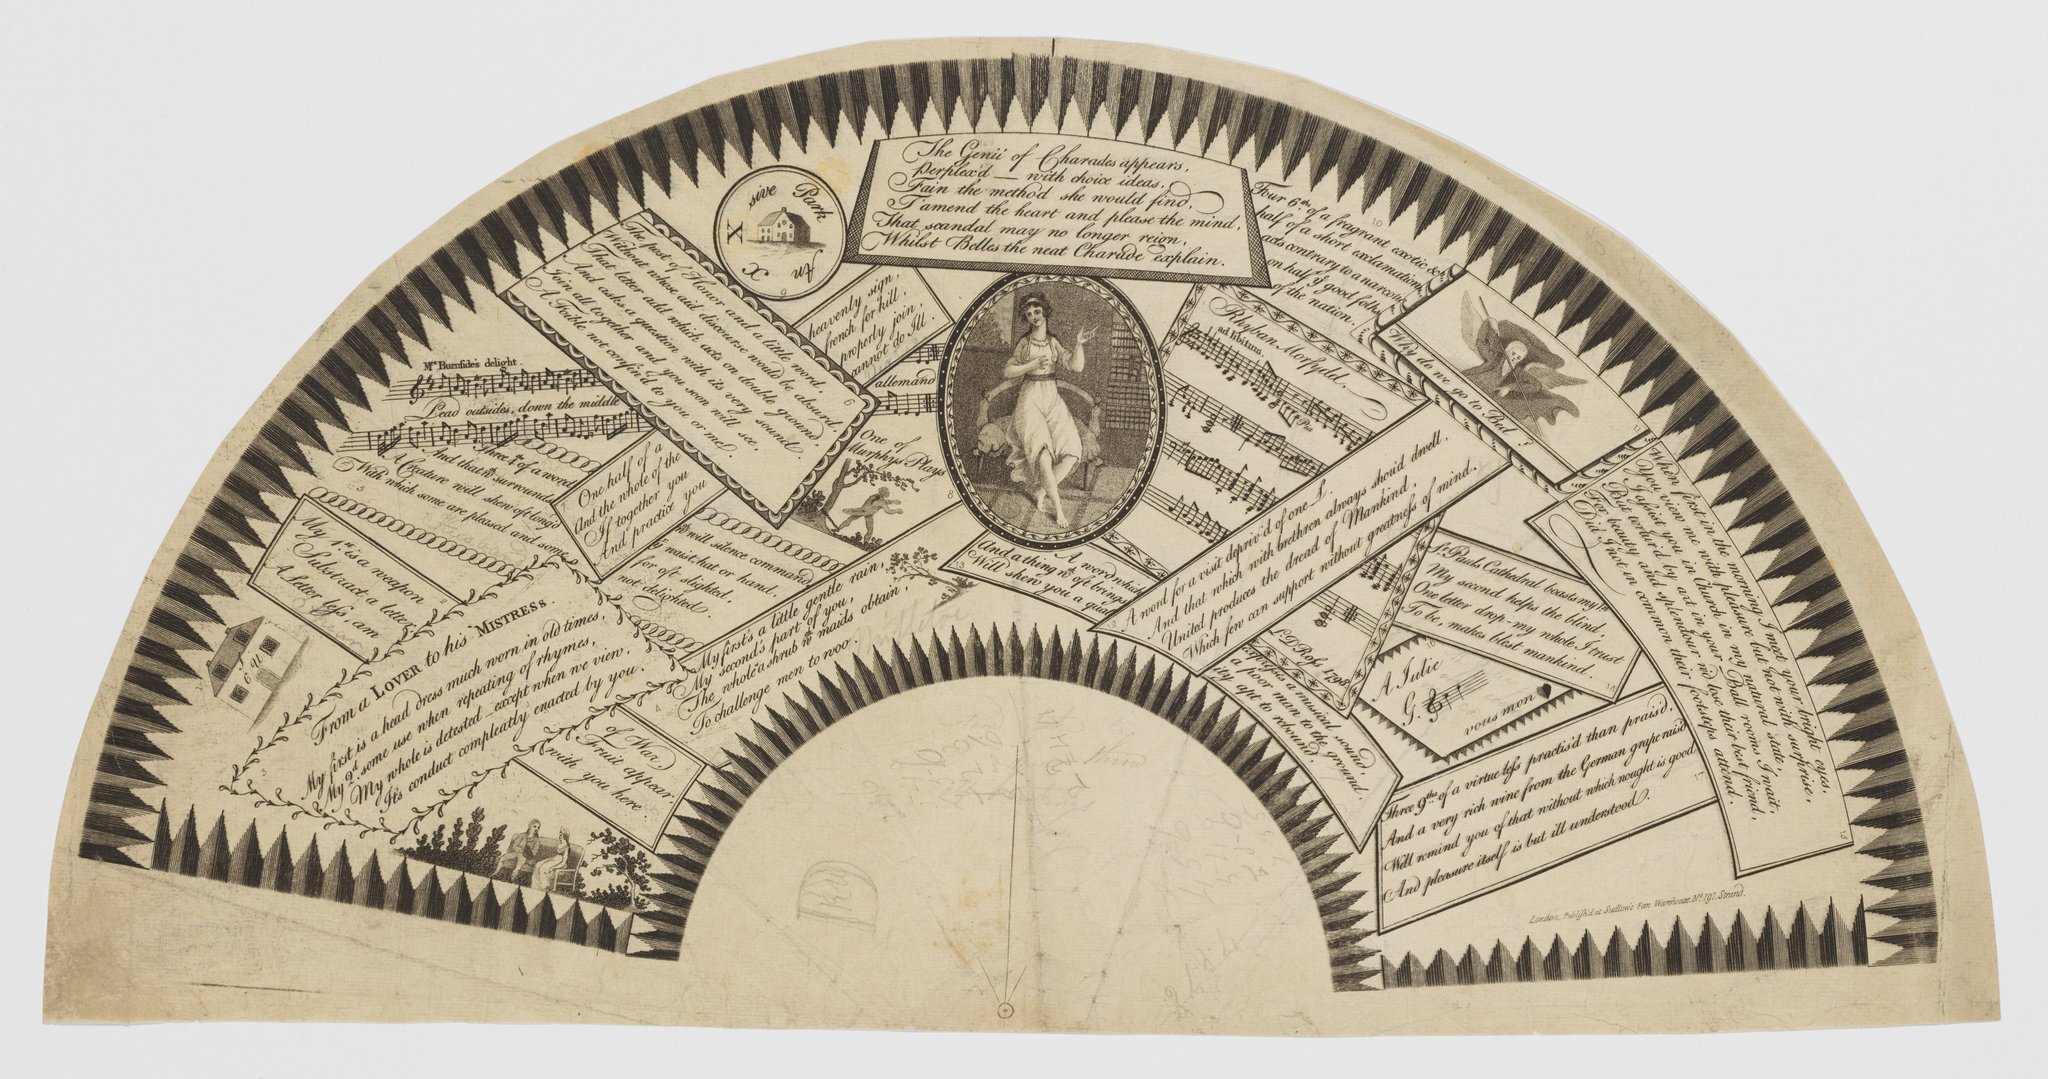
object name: print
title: Fan leaf with seventeen charades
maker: anonymous, british, 18th century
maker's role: artist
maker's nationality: british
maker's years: 1700-1800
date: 1701-1800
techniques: engraving